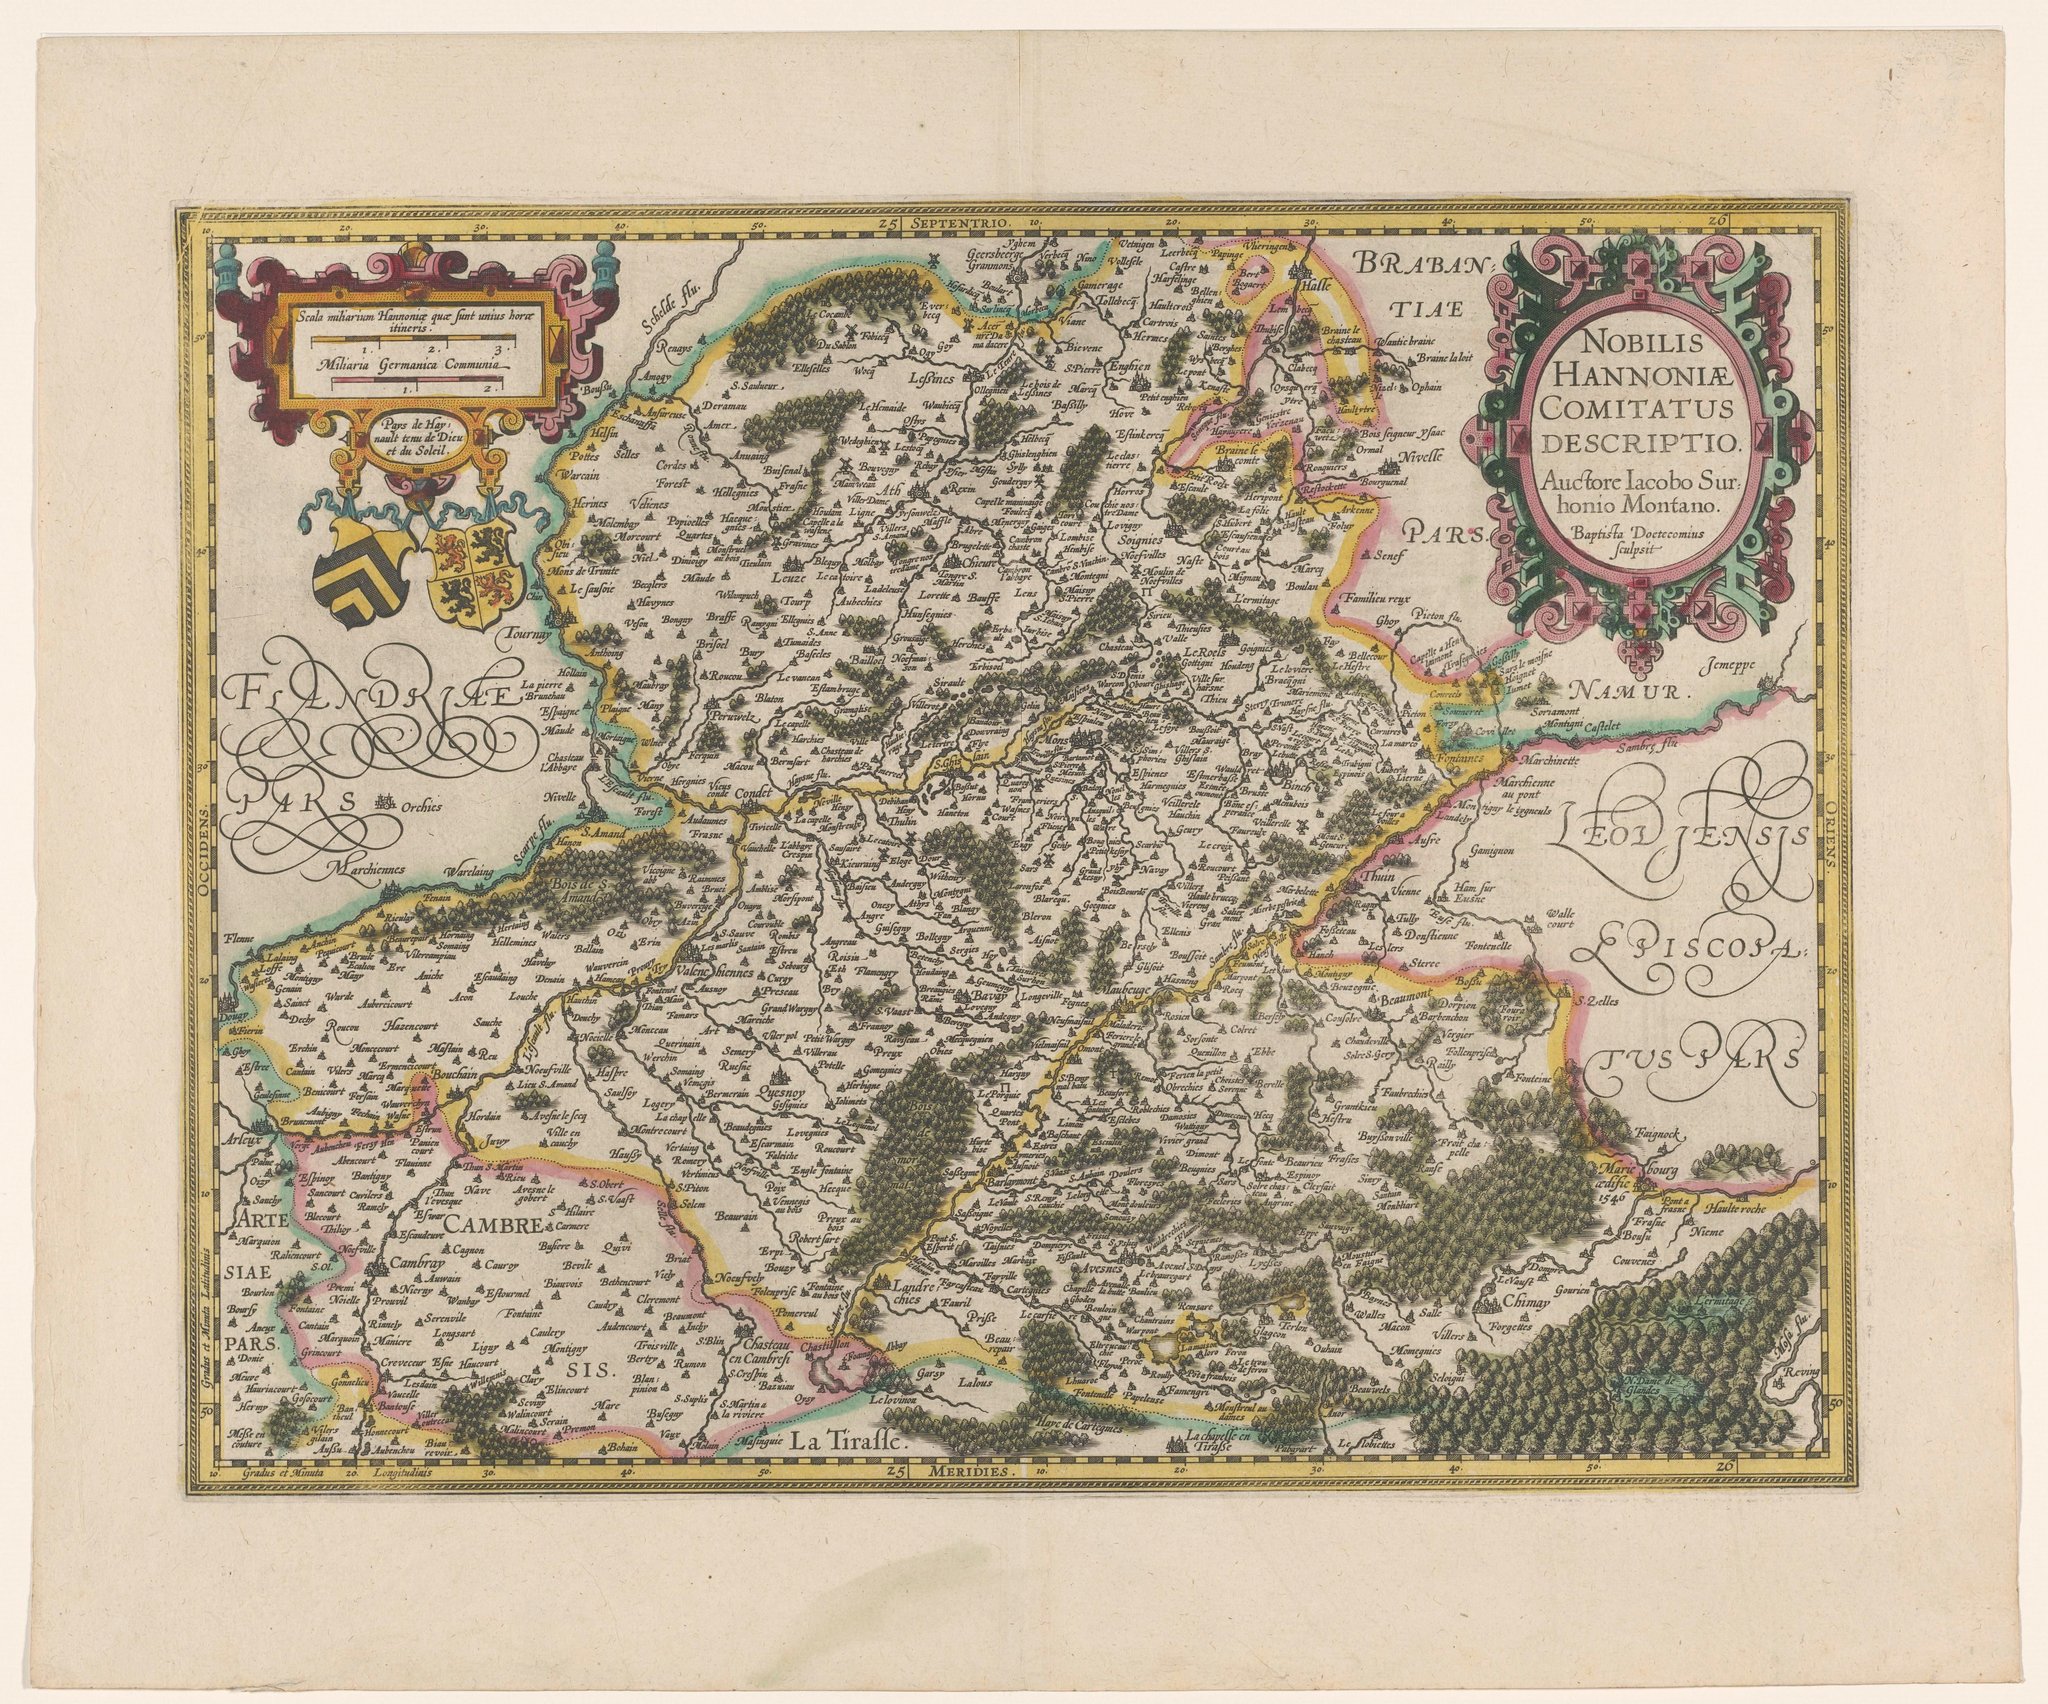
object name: map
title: Nobilis Hannoniae Comitatus descriptio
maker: joannes van doetechum (ii)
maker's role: print maker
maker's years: 1558-1630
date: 1633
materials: paper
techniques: engraving, hand coloring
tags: maps of separate countries or regions, coat of arms (as symbol of the state, etc.) (+ province; provincial), henegouwen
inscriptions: collector's mark: Lugt 2228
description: Kaart van het graafschap Henegouwen. Rechtsboven de titelcartouche. Linksboven een cartouche met twee schaalstokken: 3 Scala miliarium Hannoniae quae sunt unius horae itineris / 2 Miliaria Germanica Communia. De kaart is voorzien van een gradenverdeling langs de randen. Met Franse tekst op verso.